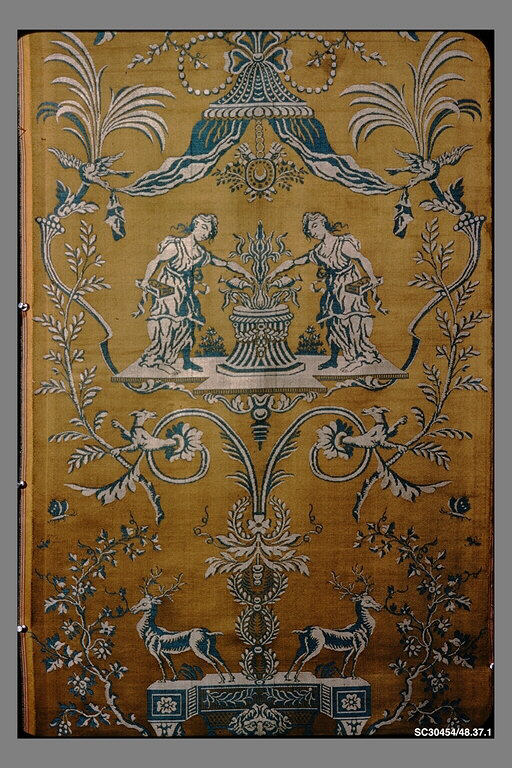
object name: panel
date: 1780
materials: silk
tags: birds,men,deer,flowers,leaves